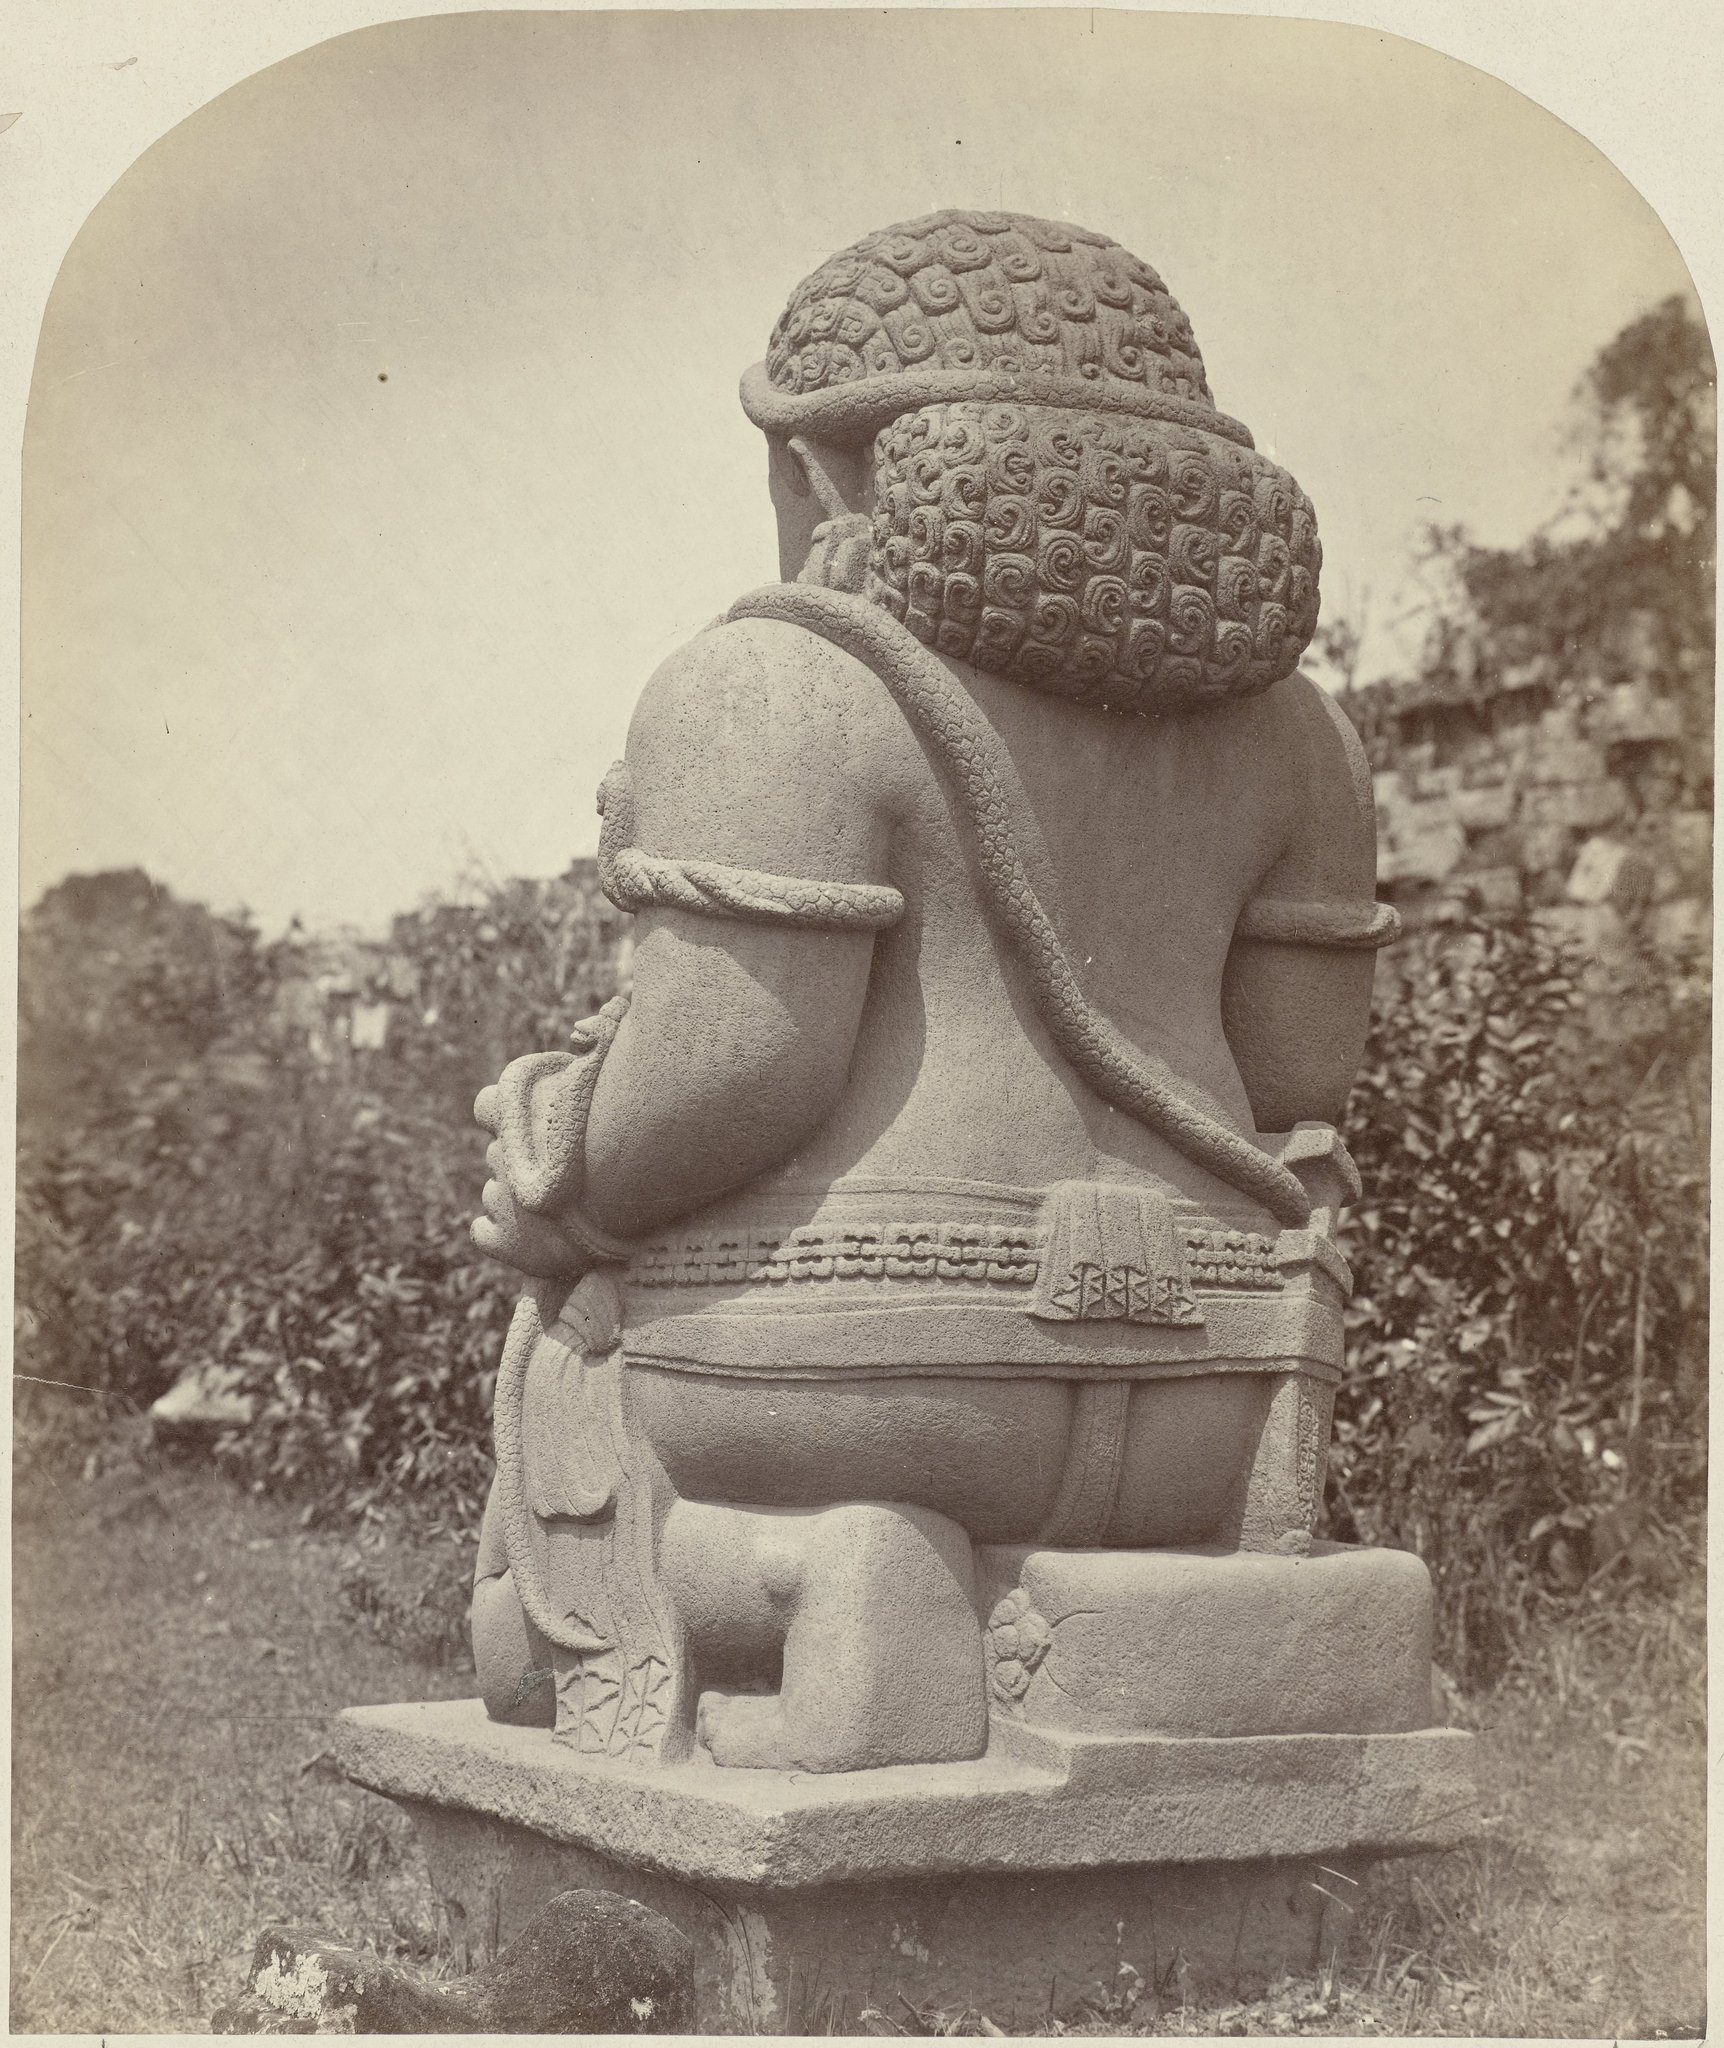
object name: photograph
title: Candi Sewu (Temple complex)(Buddhist) one of the two colossal rakshasas at the east entrance, rear view. Yogyakarta district, D.I. Yogyakarta province, 8th -9th century.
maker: isidore kinsbergen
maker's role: fotograaf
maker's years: 1821-1905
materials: cardboard, paper, photographic support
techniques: albumen print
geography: java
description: Een raksasa, een mensetende reusachtige demoon die leeft in de wildernis en in deze fungeert als tempelbewaker van de Tjandi Sewu.